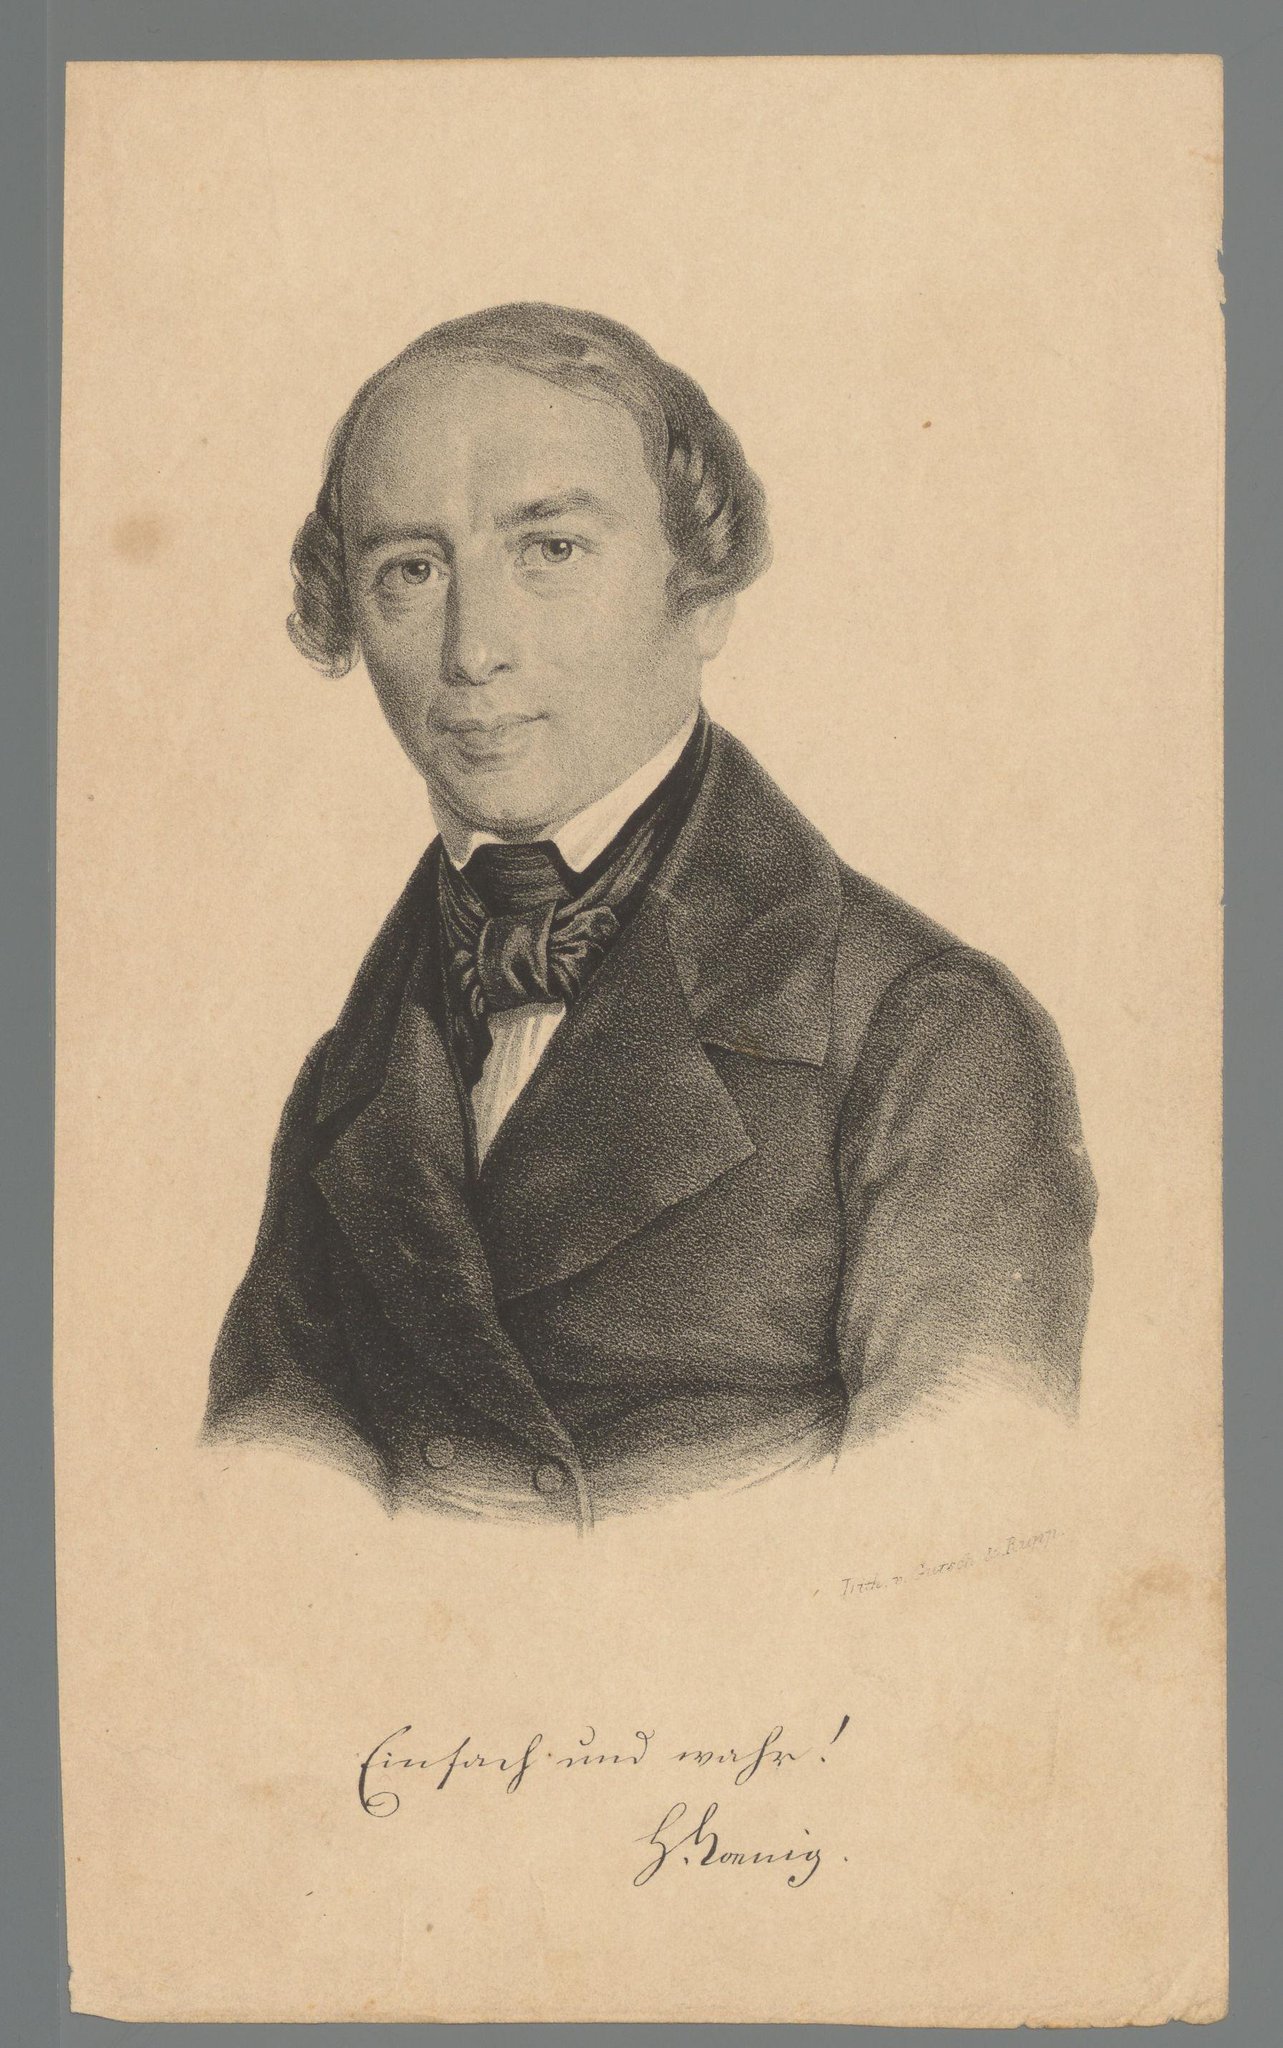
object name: print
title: Portret van een onbekende man, mogelijk H. Honnig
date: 1820-1860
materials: paper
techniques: lithograph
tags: adult man, historical persons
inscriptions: collector's mark: Lugt 2228